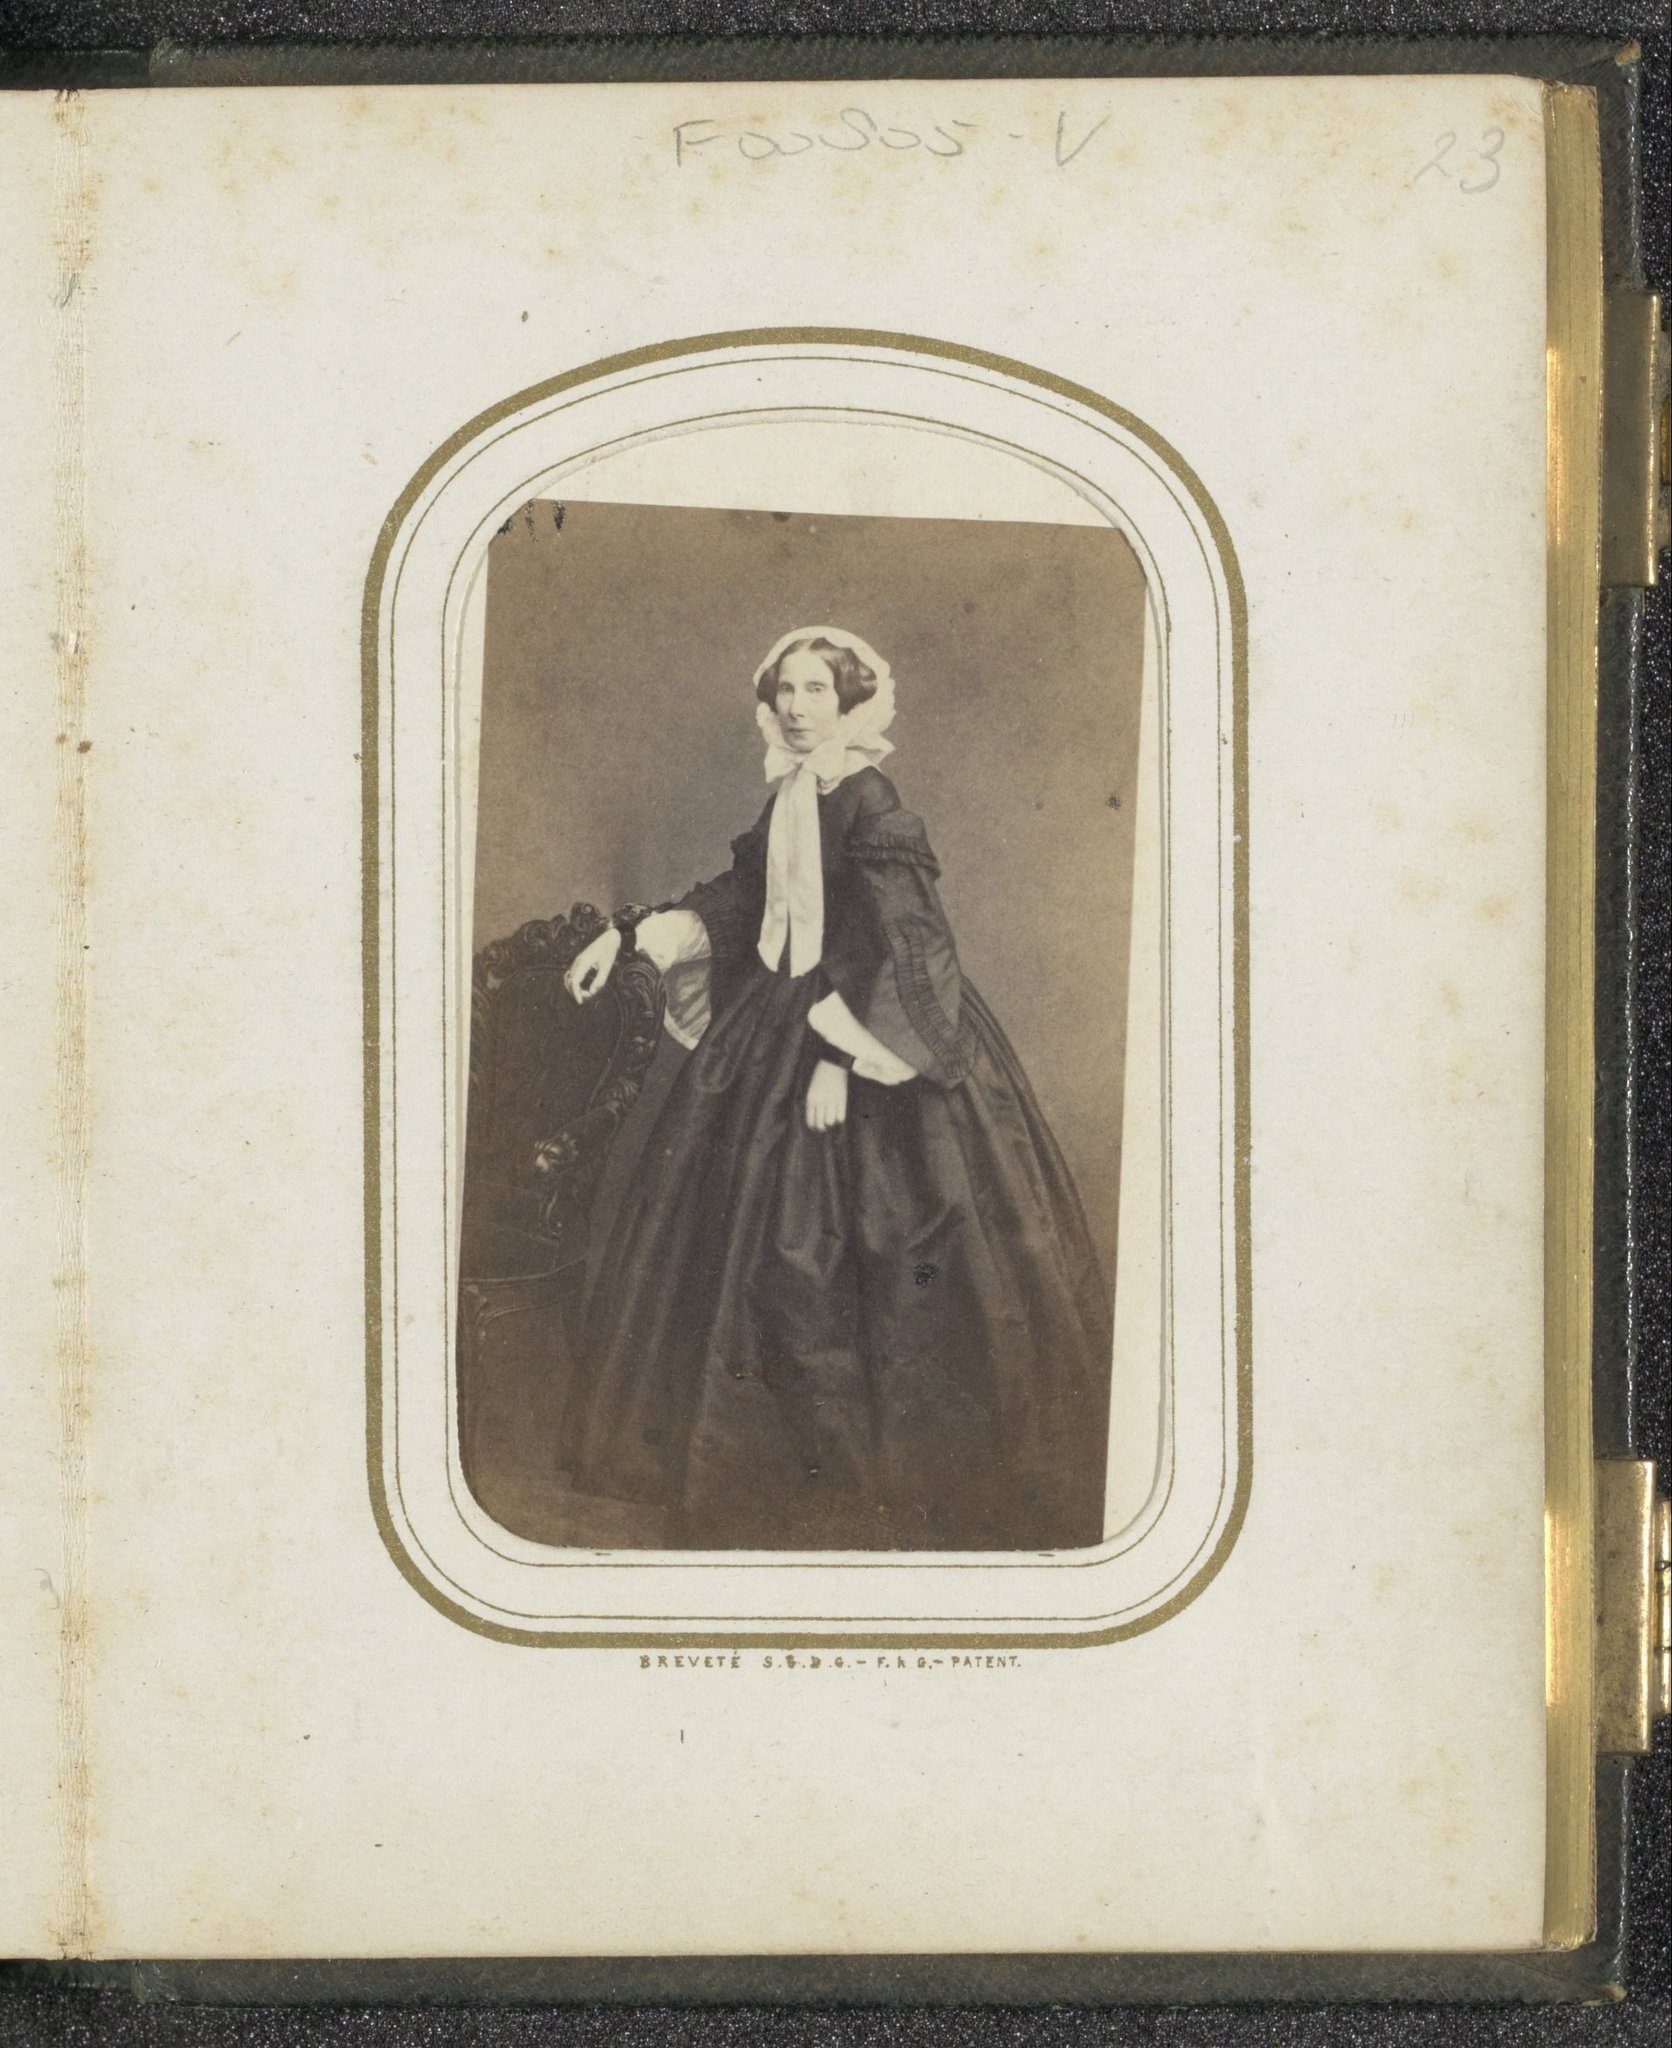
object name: carte de visite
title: Portret van Louise van Pruisen, echtgenote van prins Frederik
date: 1861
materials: cardboard, paper, photographic support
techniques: albumen print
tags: studio requisites ~ photographer, head-gear, historical persons, princess, dress, gown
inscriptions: address: ‘Berlin Friedrich u. Mohren Str. Ecke Eingang Mohrenstr.’, inscription: ‘Königin Friedrich d. Niederl.’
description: Onderdeel van Fotoalbum met 29 foto's van Nederlandse vorsten.